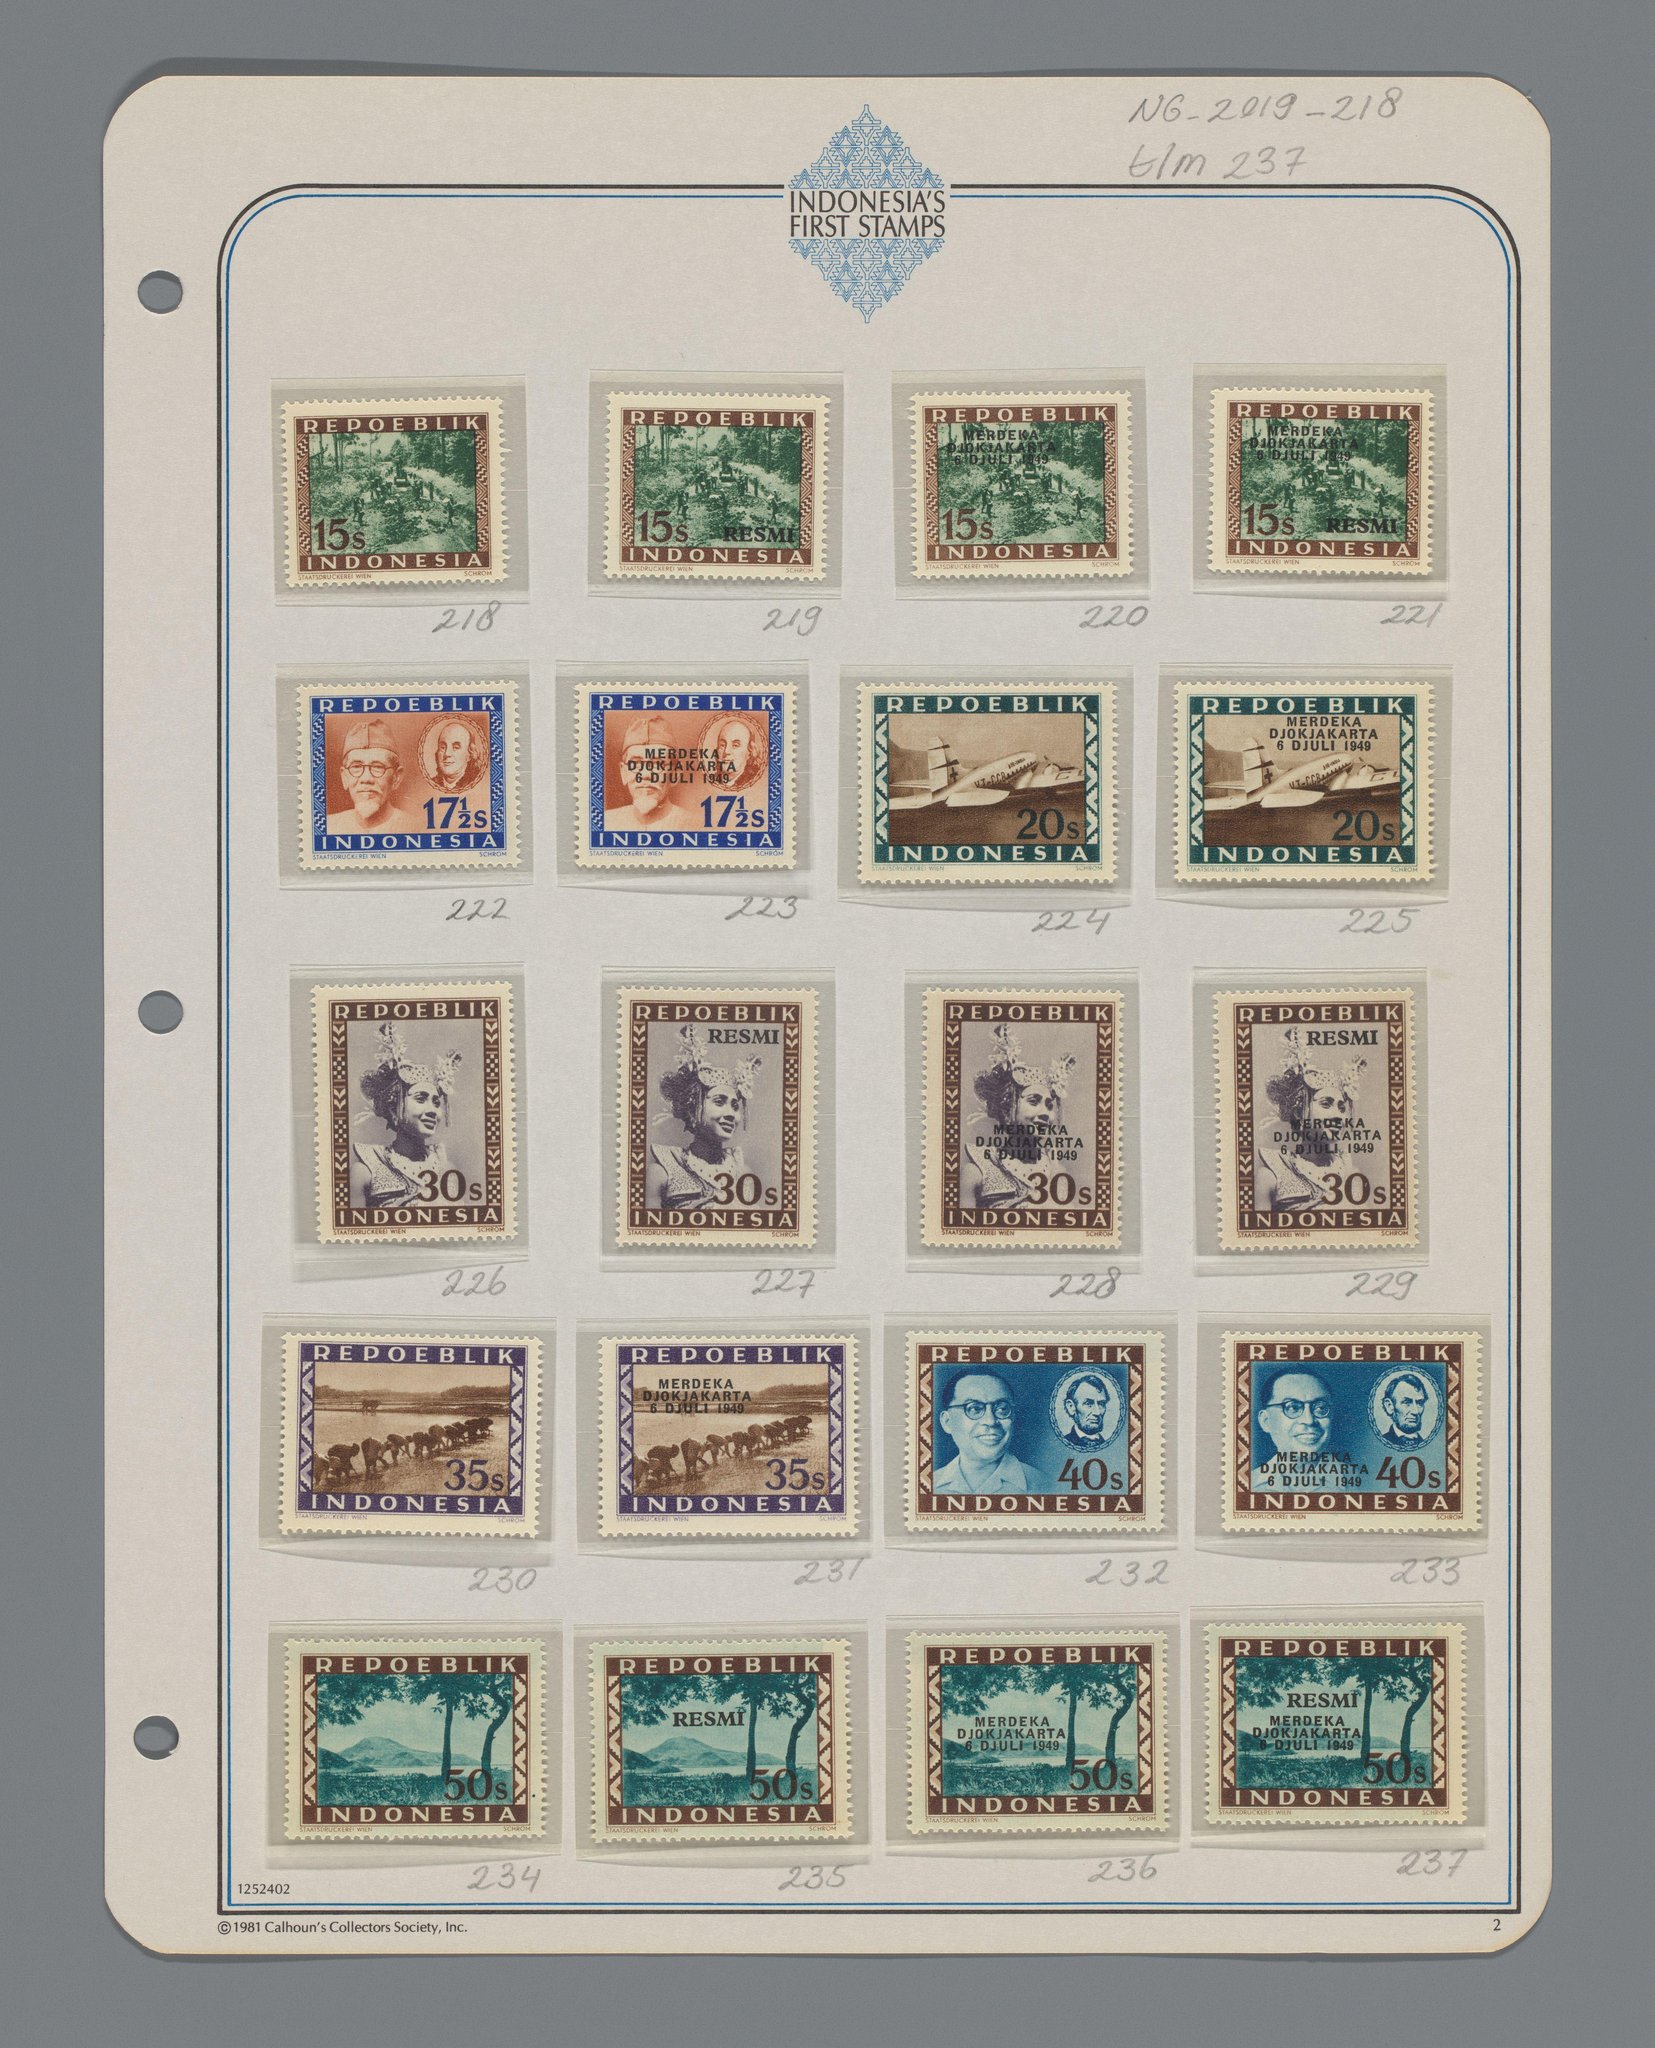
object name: postage stamp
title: Postzegel Republik Indonesia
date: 1949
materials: paper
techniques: photoaquatint, engraving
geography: vienna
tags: indonesia